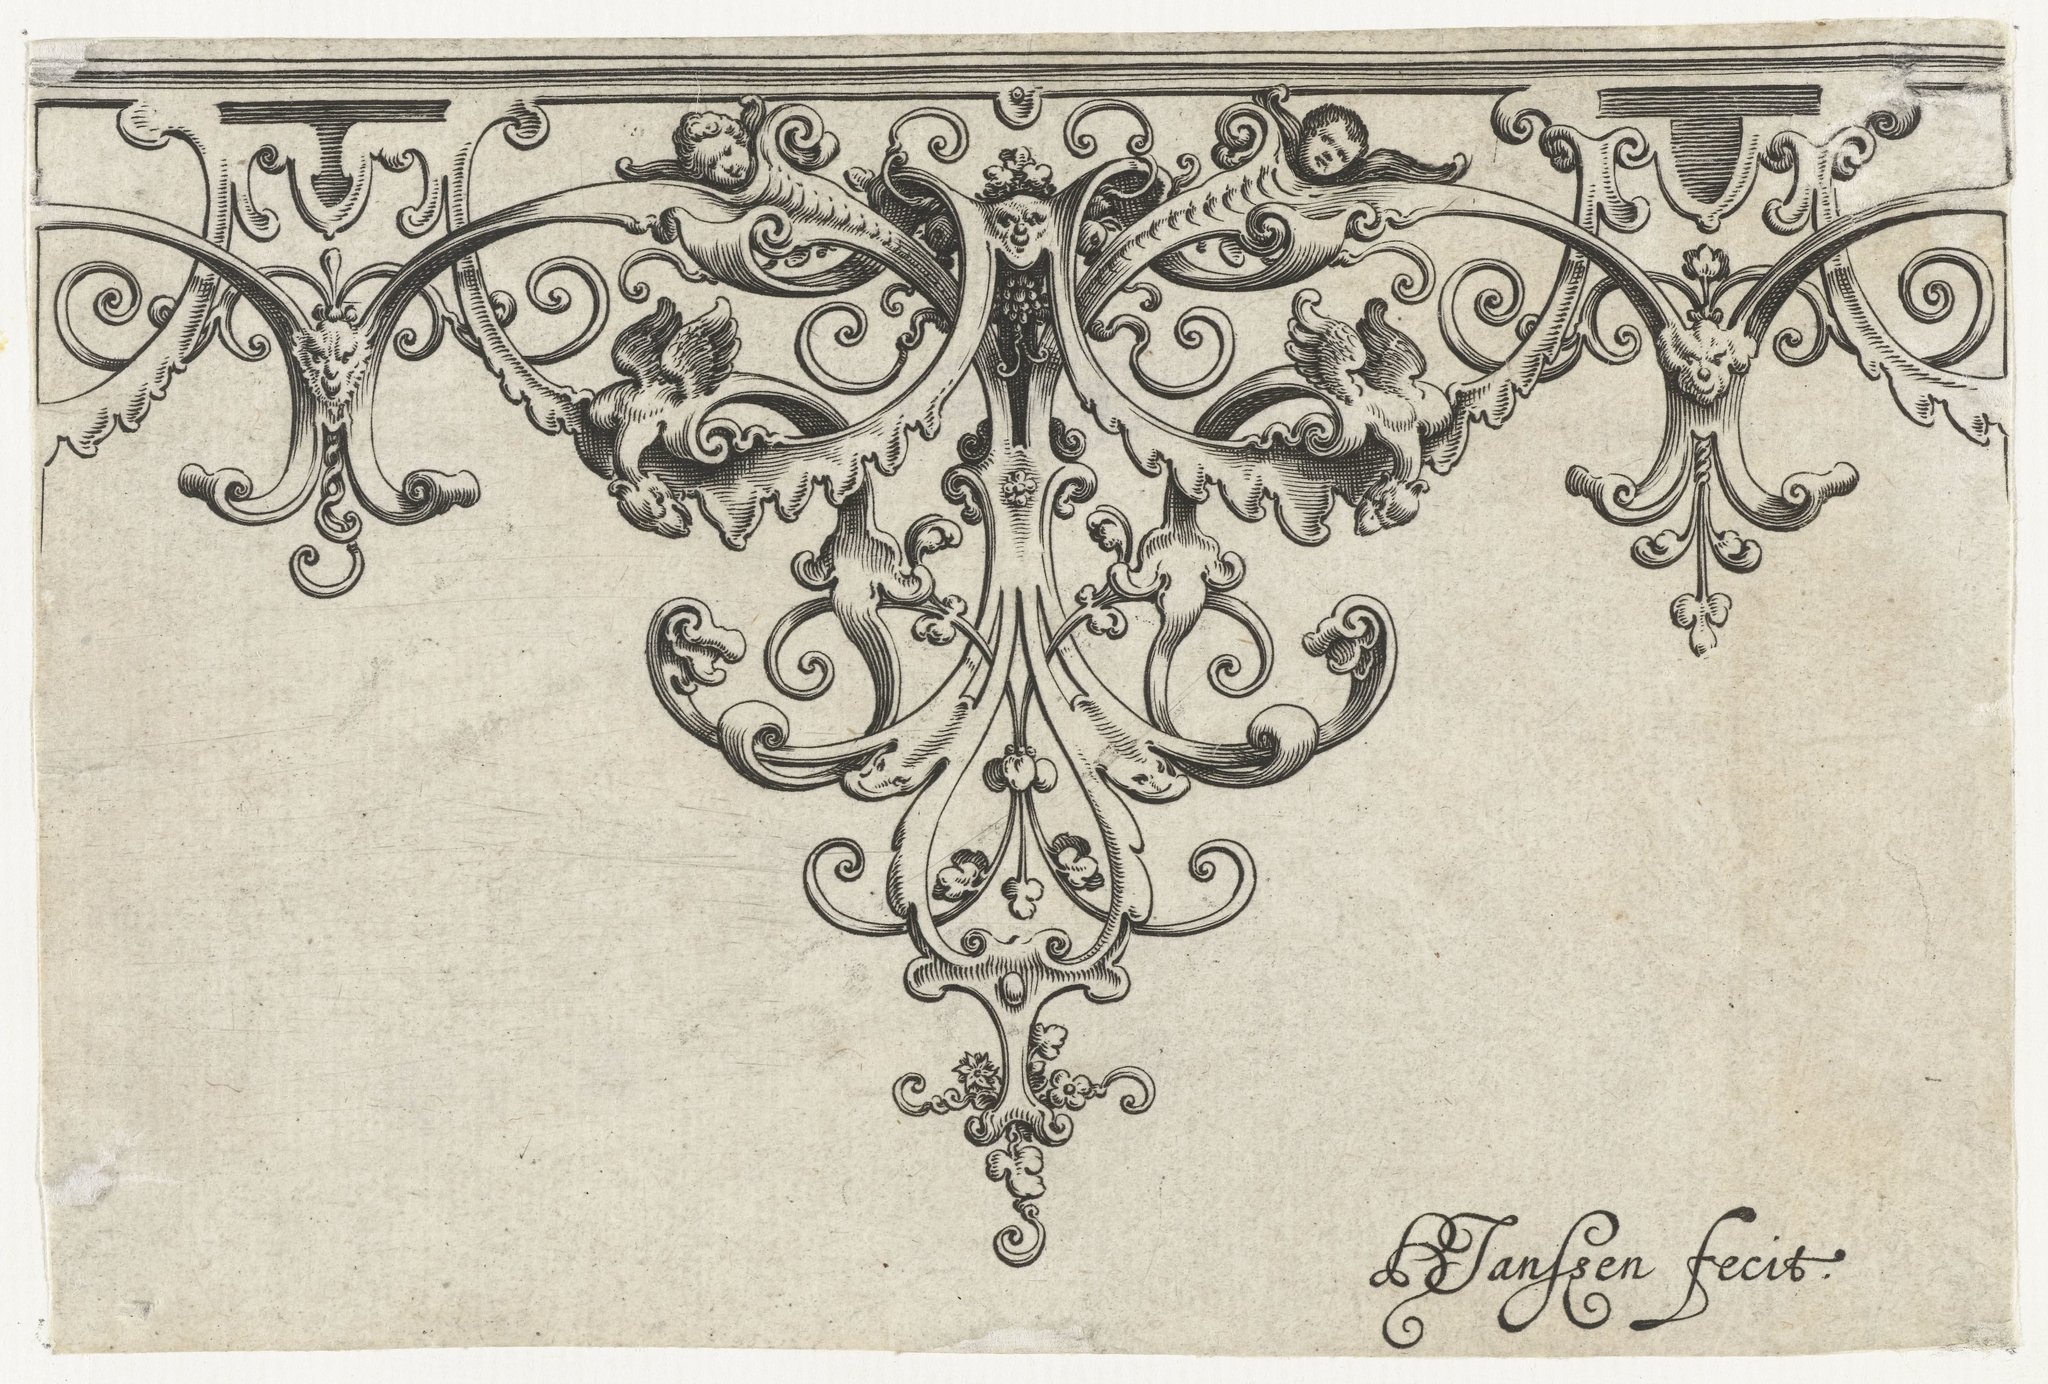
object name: print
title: Spits met ranken in de vorm van een lamberkijn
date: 1631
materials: paper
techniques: etching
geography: amsterdam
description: Blad uit serie met decoraties voor zilveren bekers.